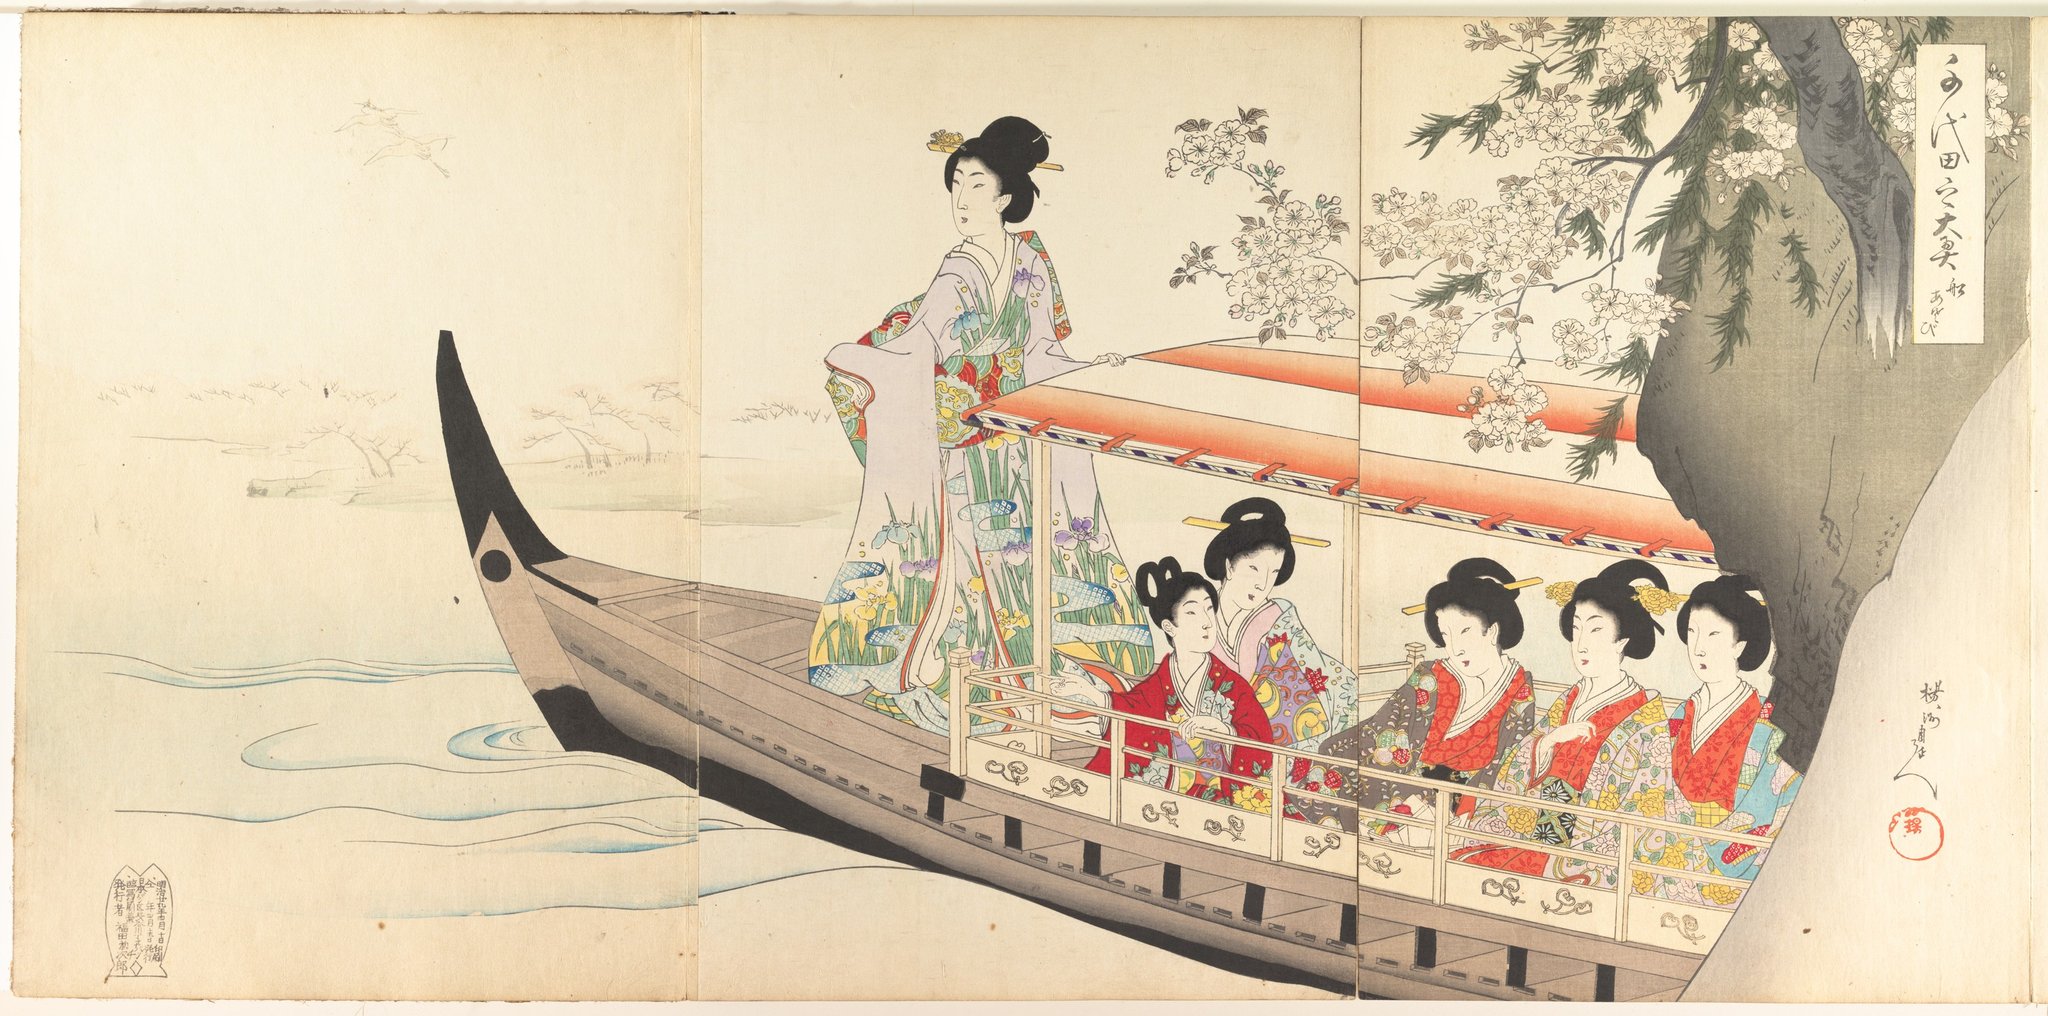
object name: print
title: Chiyoda Castle (Album of Women)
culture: japanese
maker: yōshū (hashimoto) chikanobu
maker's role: artist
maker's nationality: japanese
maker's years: 1838-1912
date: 1895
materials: ink, paper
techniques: woodblock print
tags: women,boats